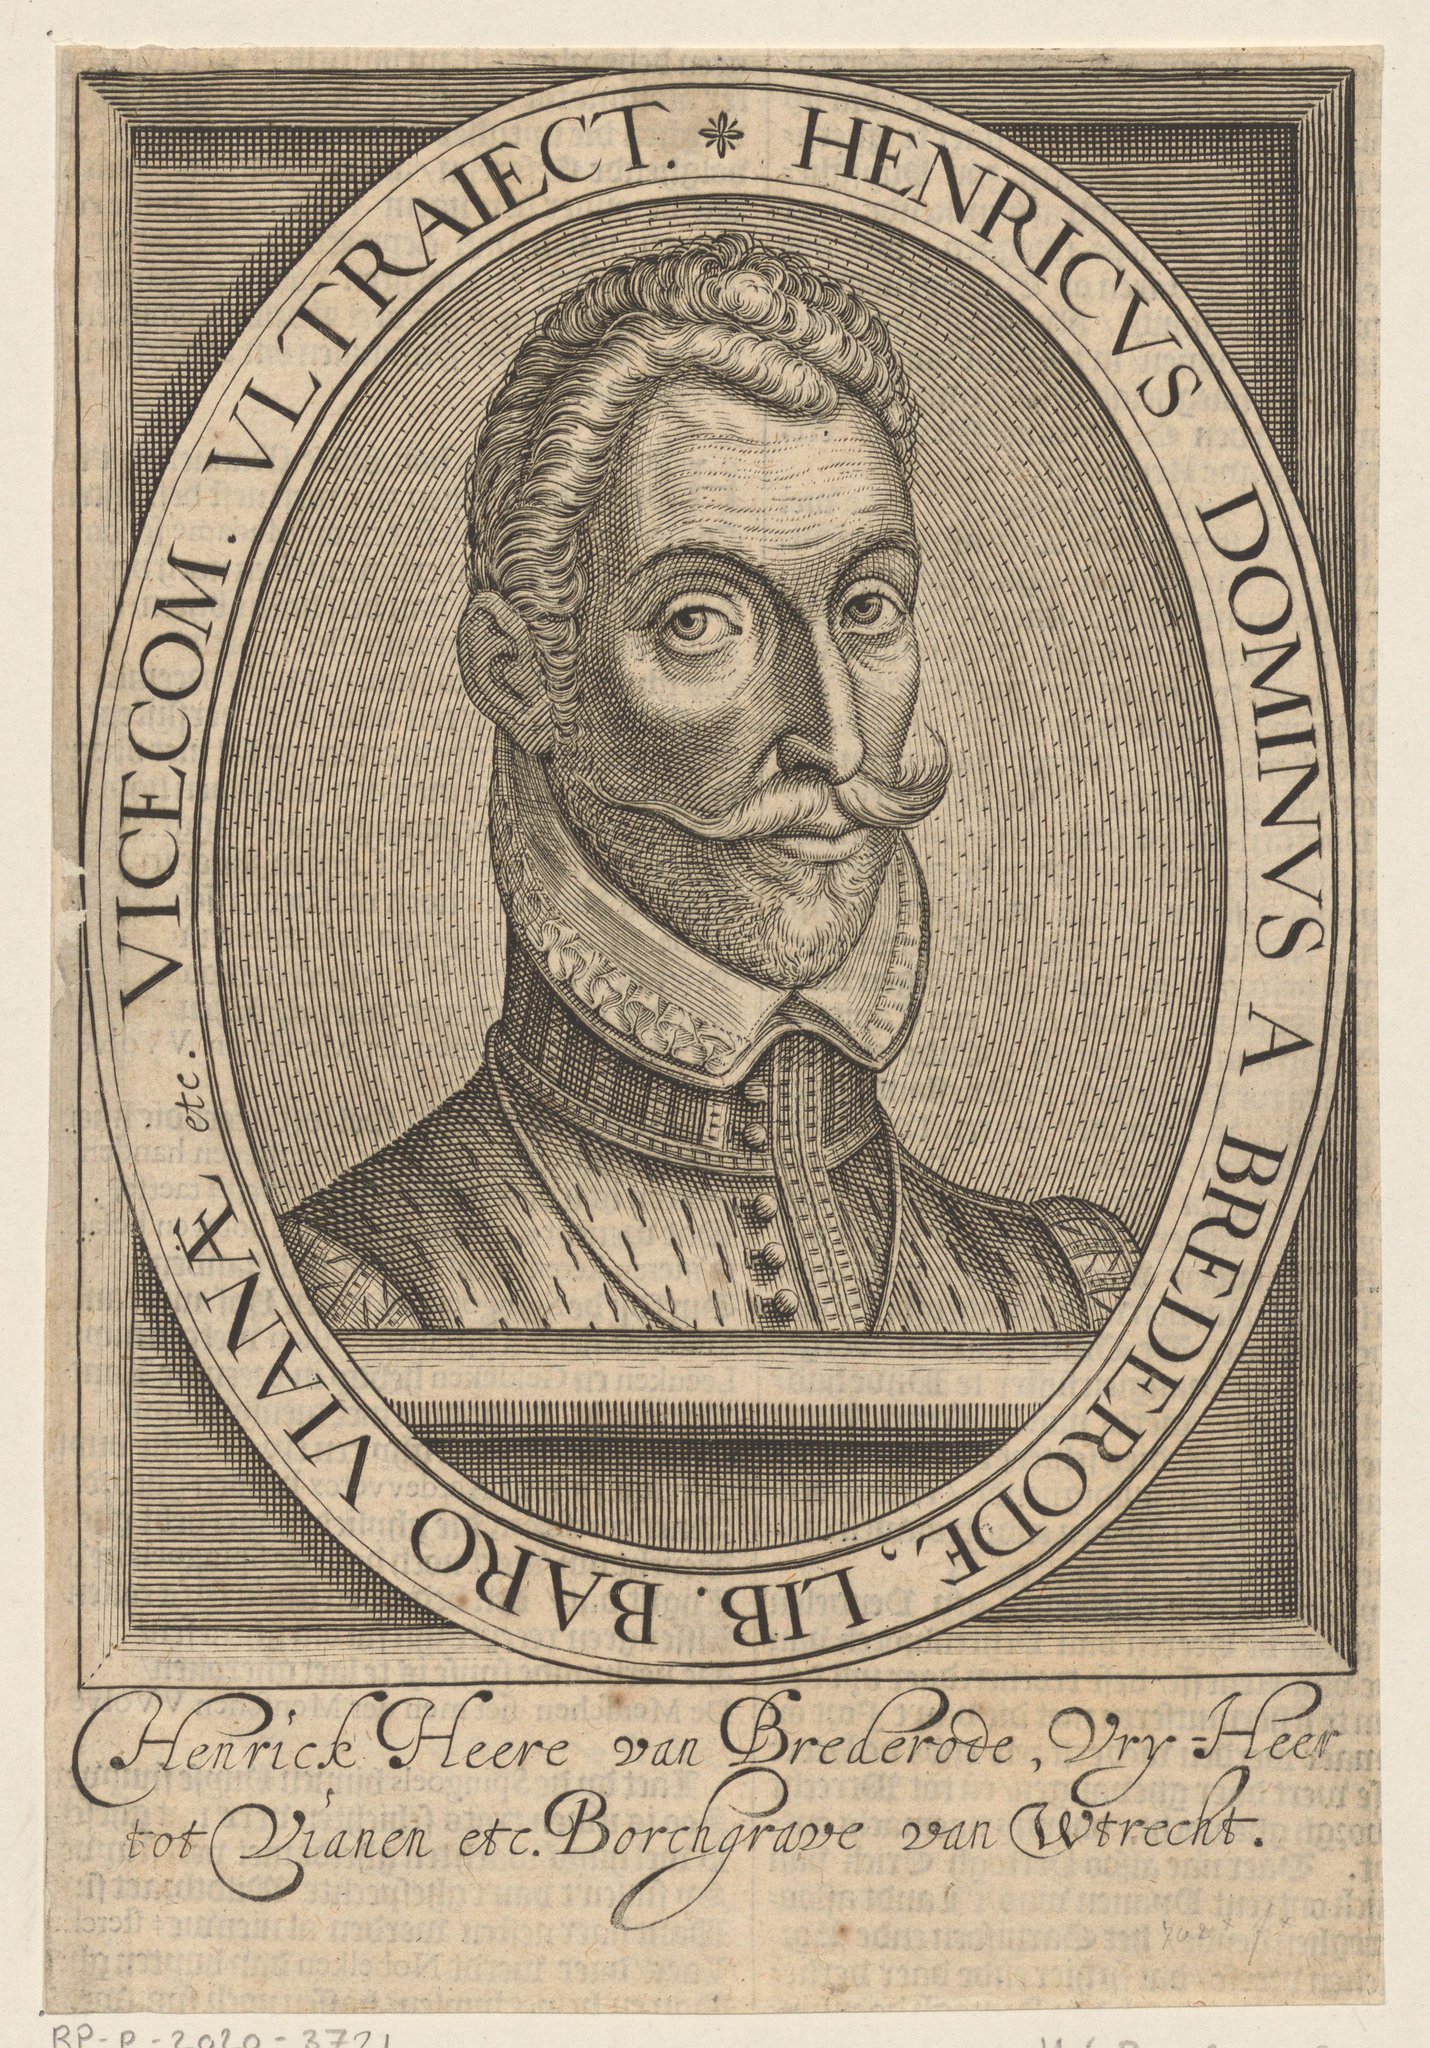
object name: book illustration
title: Portret van Hendrik van Brederode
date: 1614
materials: paper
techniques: engraving, letterpress printing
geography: the hague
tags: historical persons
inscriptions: collector's mark: Lugt 2228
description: Prent uit: Meteren, Emanuel van. Historie der Nederlandscher ende haerder na-buren oorlogen ende geschiedenissen (...). Den Haag: Hillebrant Jacobsz. van Wouw (I), 1614. Prent ook gebruikt in andere edities van dit werk.